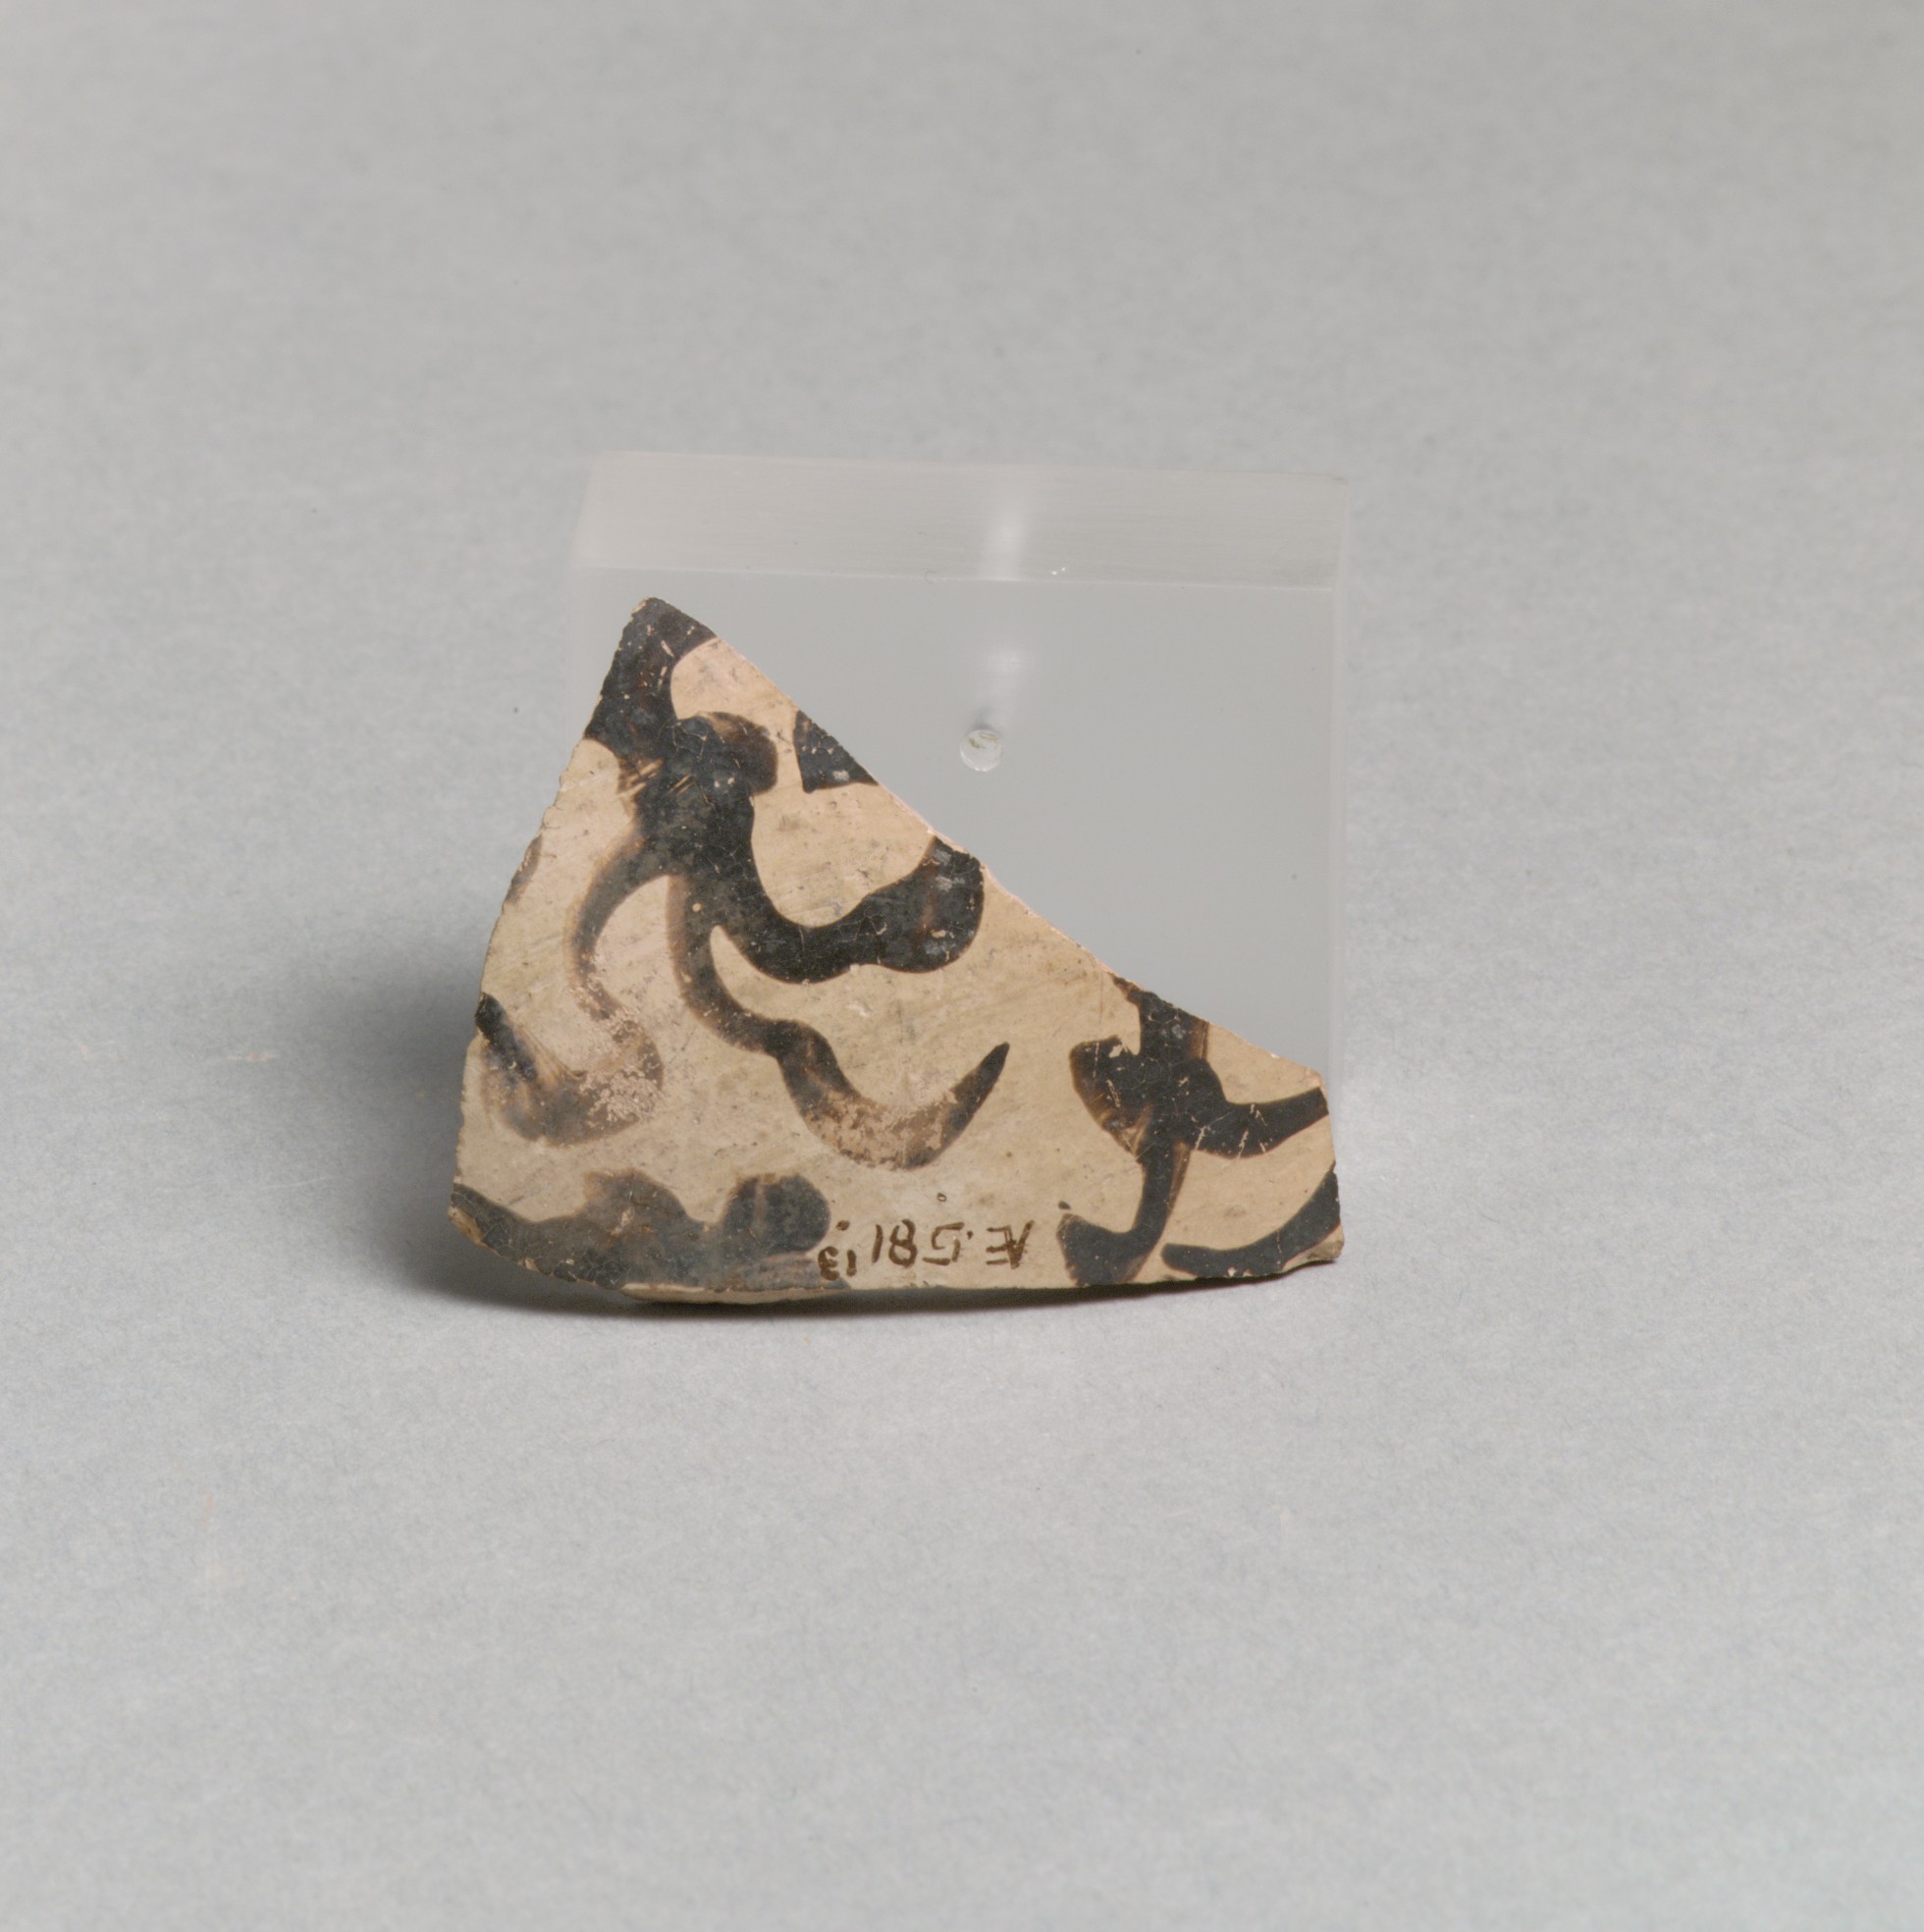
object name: vase fragment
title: Terracotta vessel fragment with marine motif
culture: minoan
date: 1450-1400 BCE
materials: terracotta